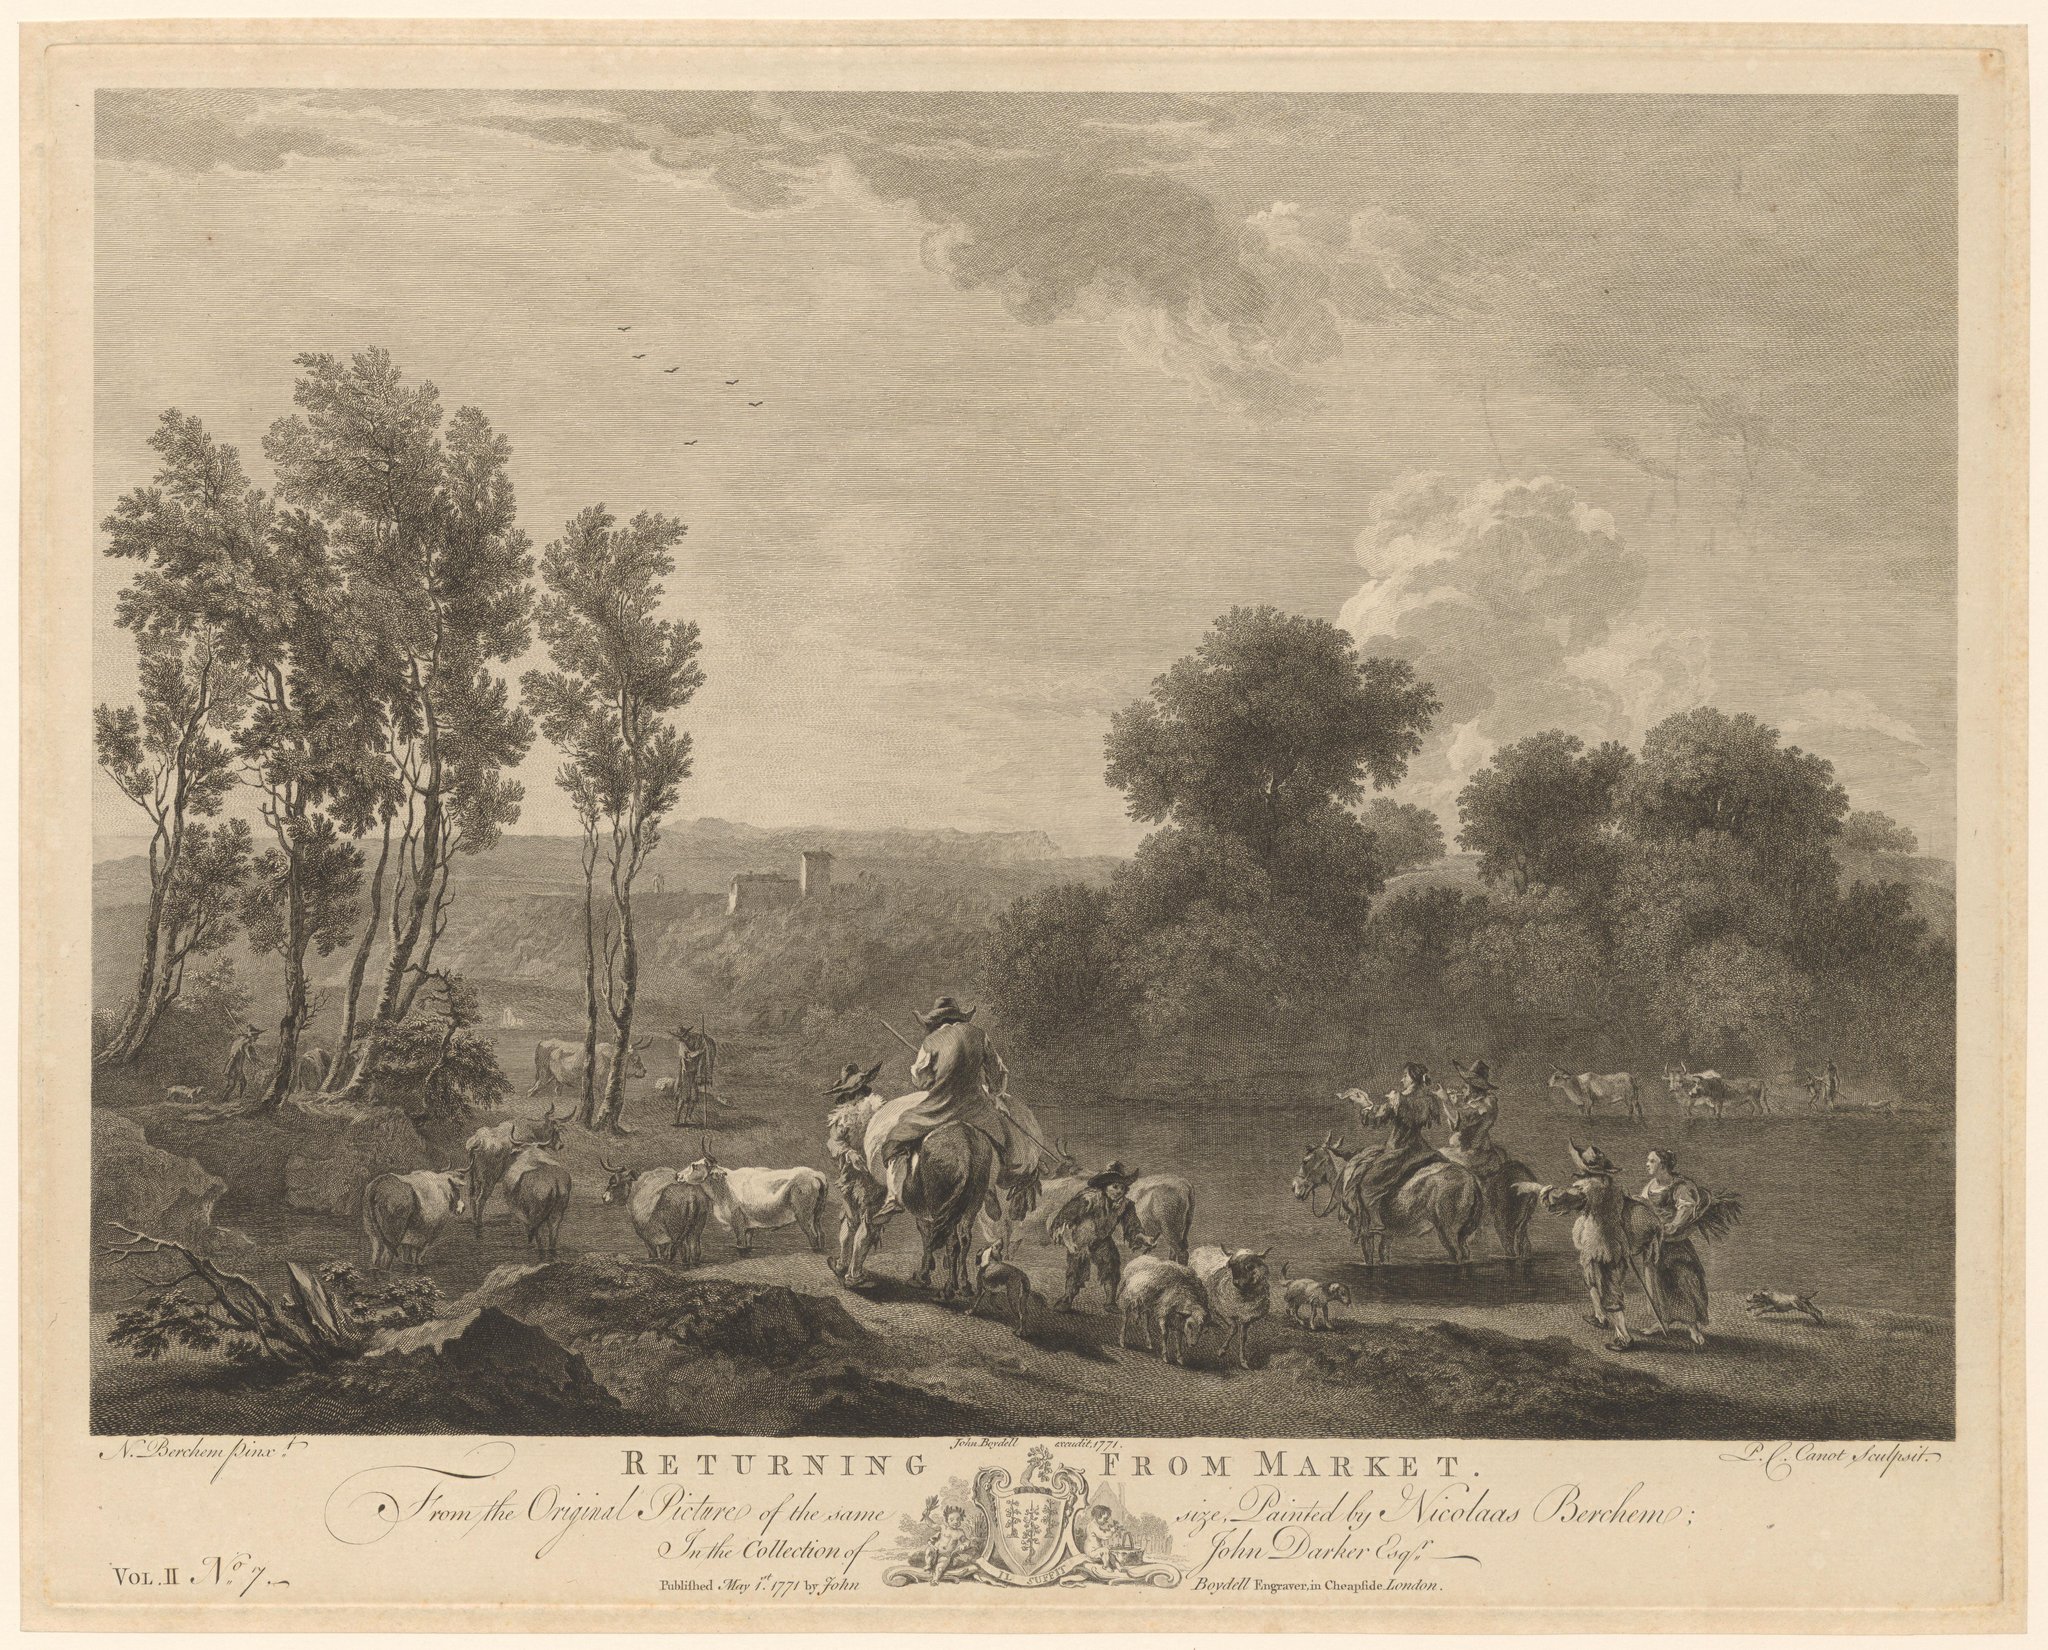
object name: print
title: Landschap met herders en reizigers aan een oever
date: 1771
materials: paper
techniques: engraving, etching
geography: london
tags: cattle, returning from the market, river bank (+ landscape with figures, staffage)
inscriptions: collector's mark: Lugt 240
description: Prent maakt deel uit het tweede deel van een serie. De complete serie is bekend onder de titel 'The Most Capital Paintings in England'. De eerste drie delen zijn uitgebracht met de serietitel 'Sculptura Britannica'. De prenten werden gepubliceerd tussen 1763-1786 en vanaf 1769 met meerdere delen uitgegeven.